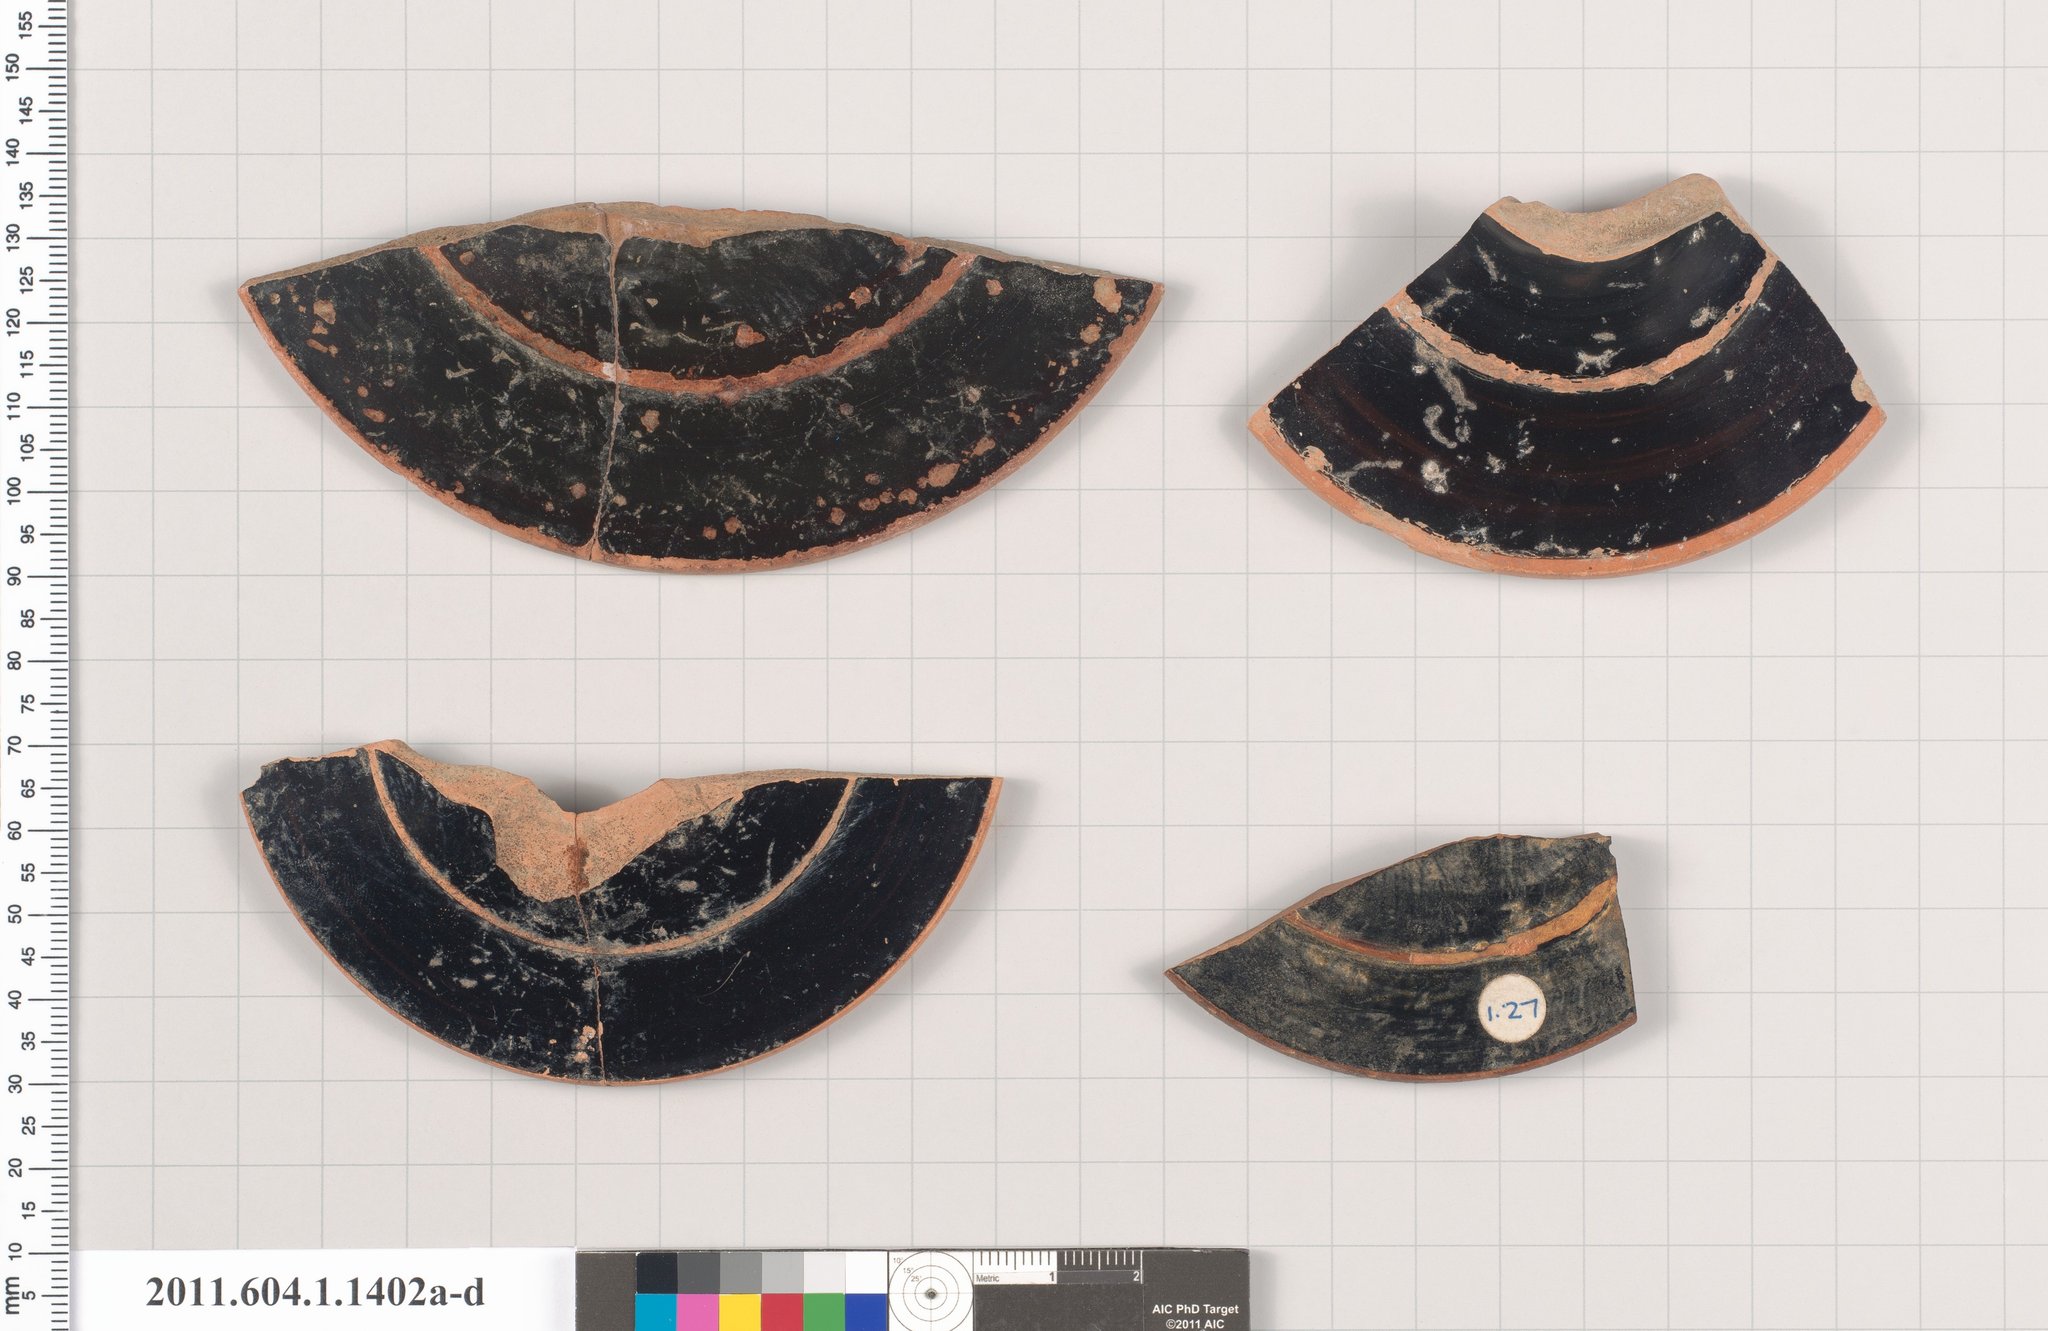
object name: kylix fragment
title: Terracotta fragments of kylikes (drinking cups)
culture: greek, attic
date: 500-401 BCE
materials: terracotta